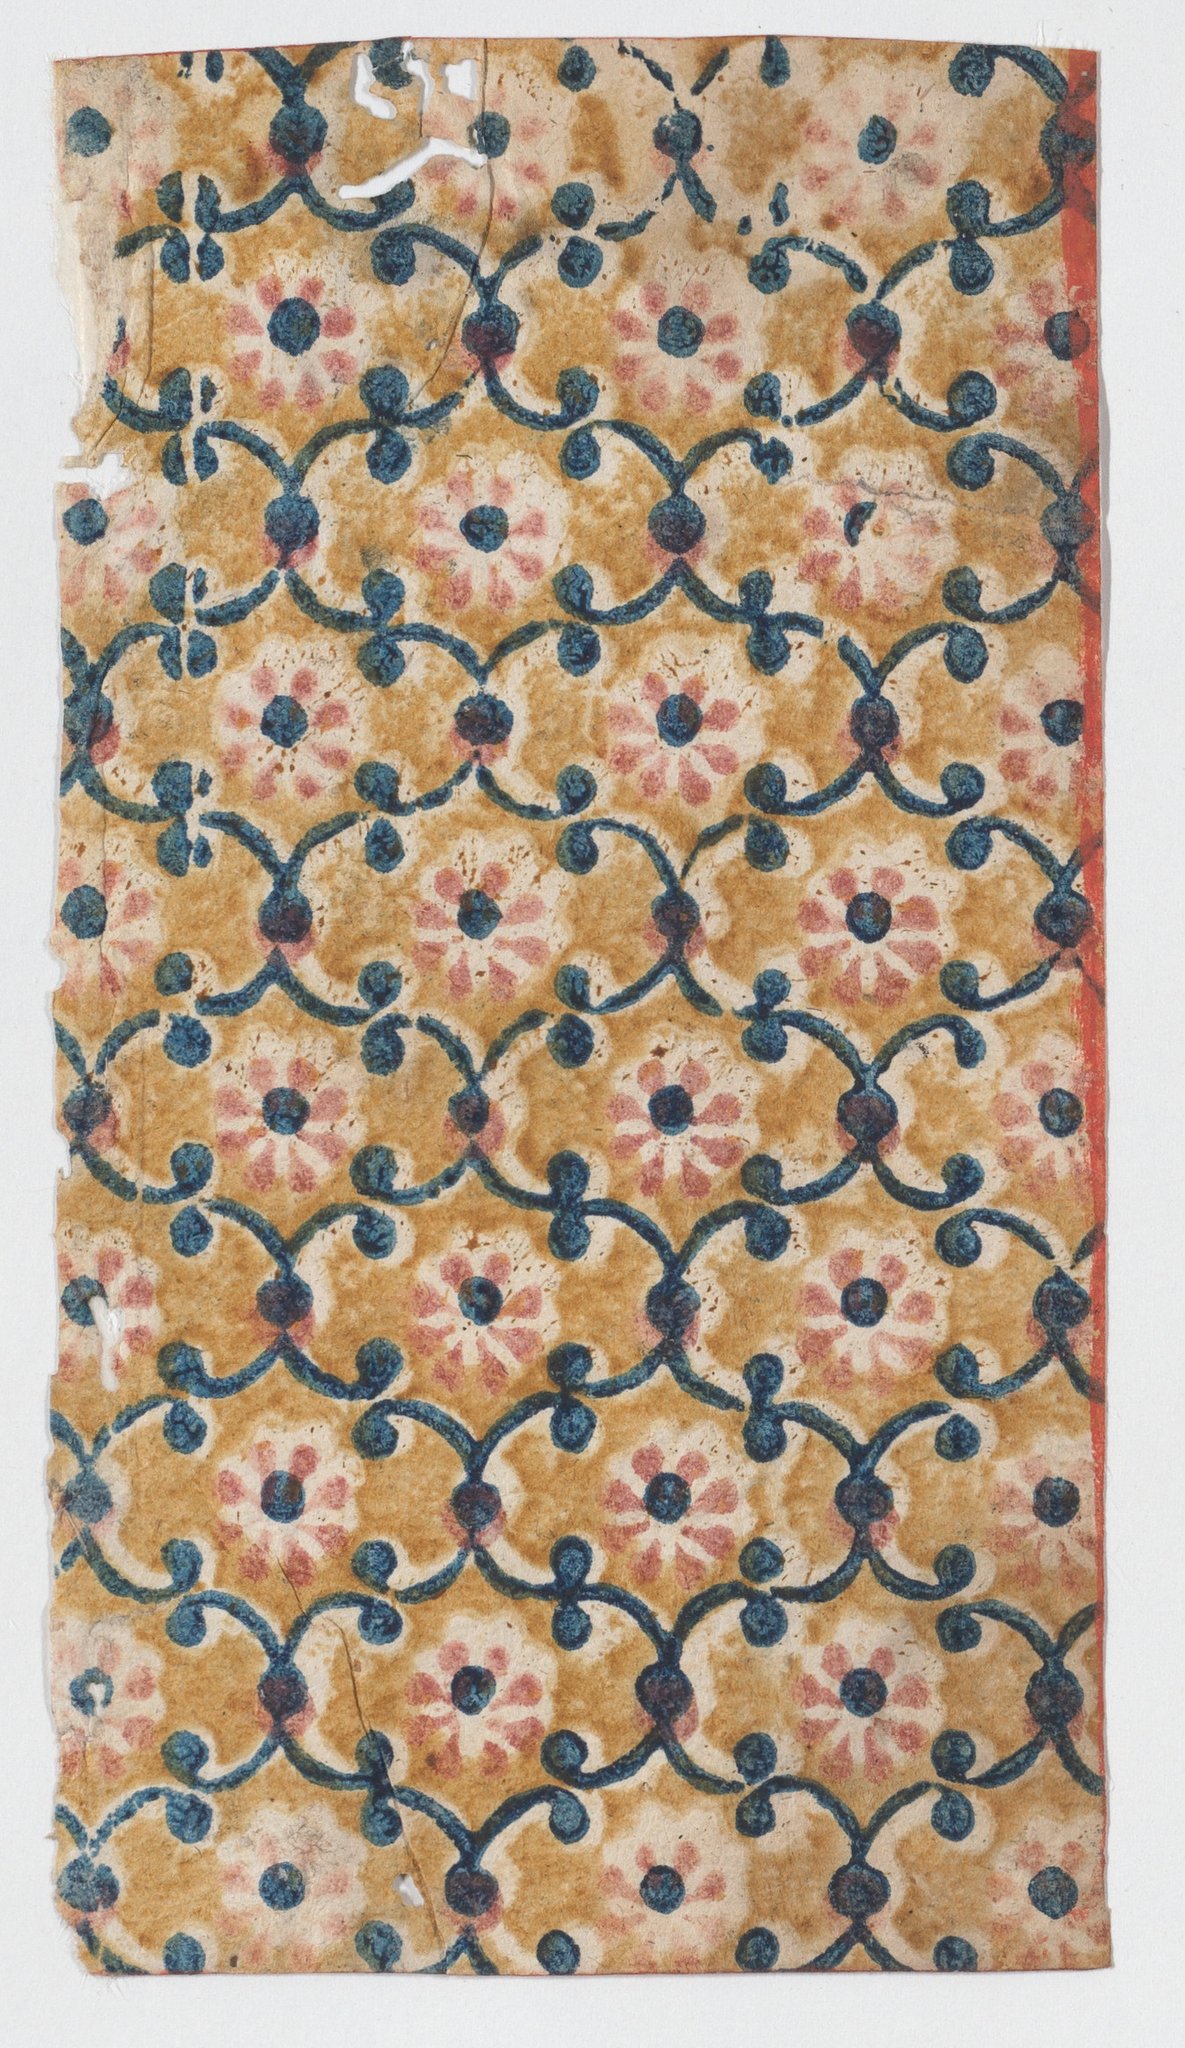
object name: print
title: Sheet with overall lattice pattern with rosettes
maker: Anonymous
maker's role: artist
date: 1801-1900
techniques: relief print